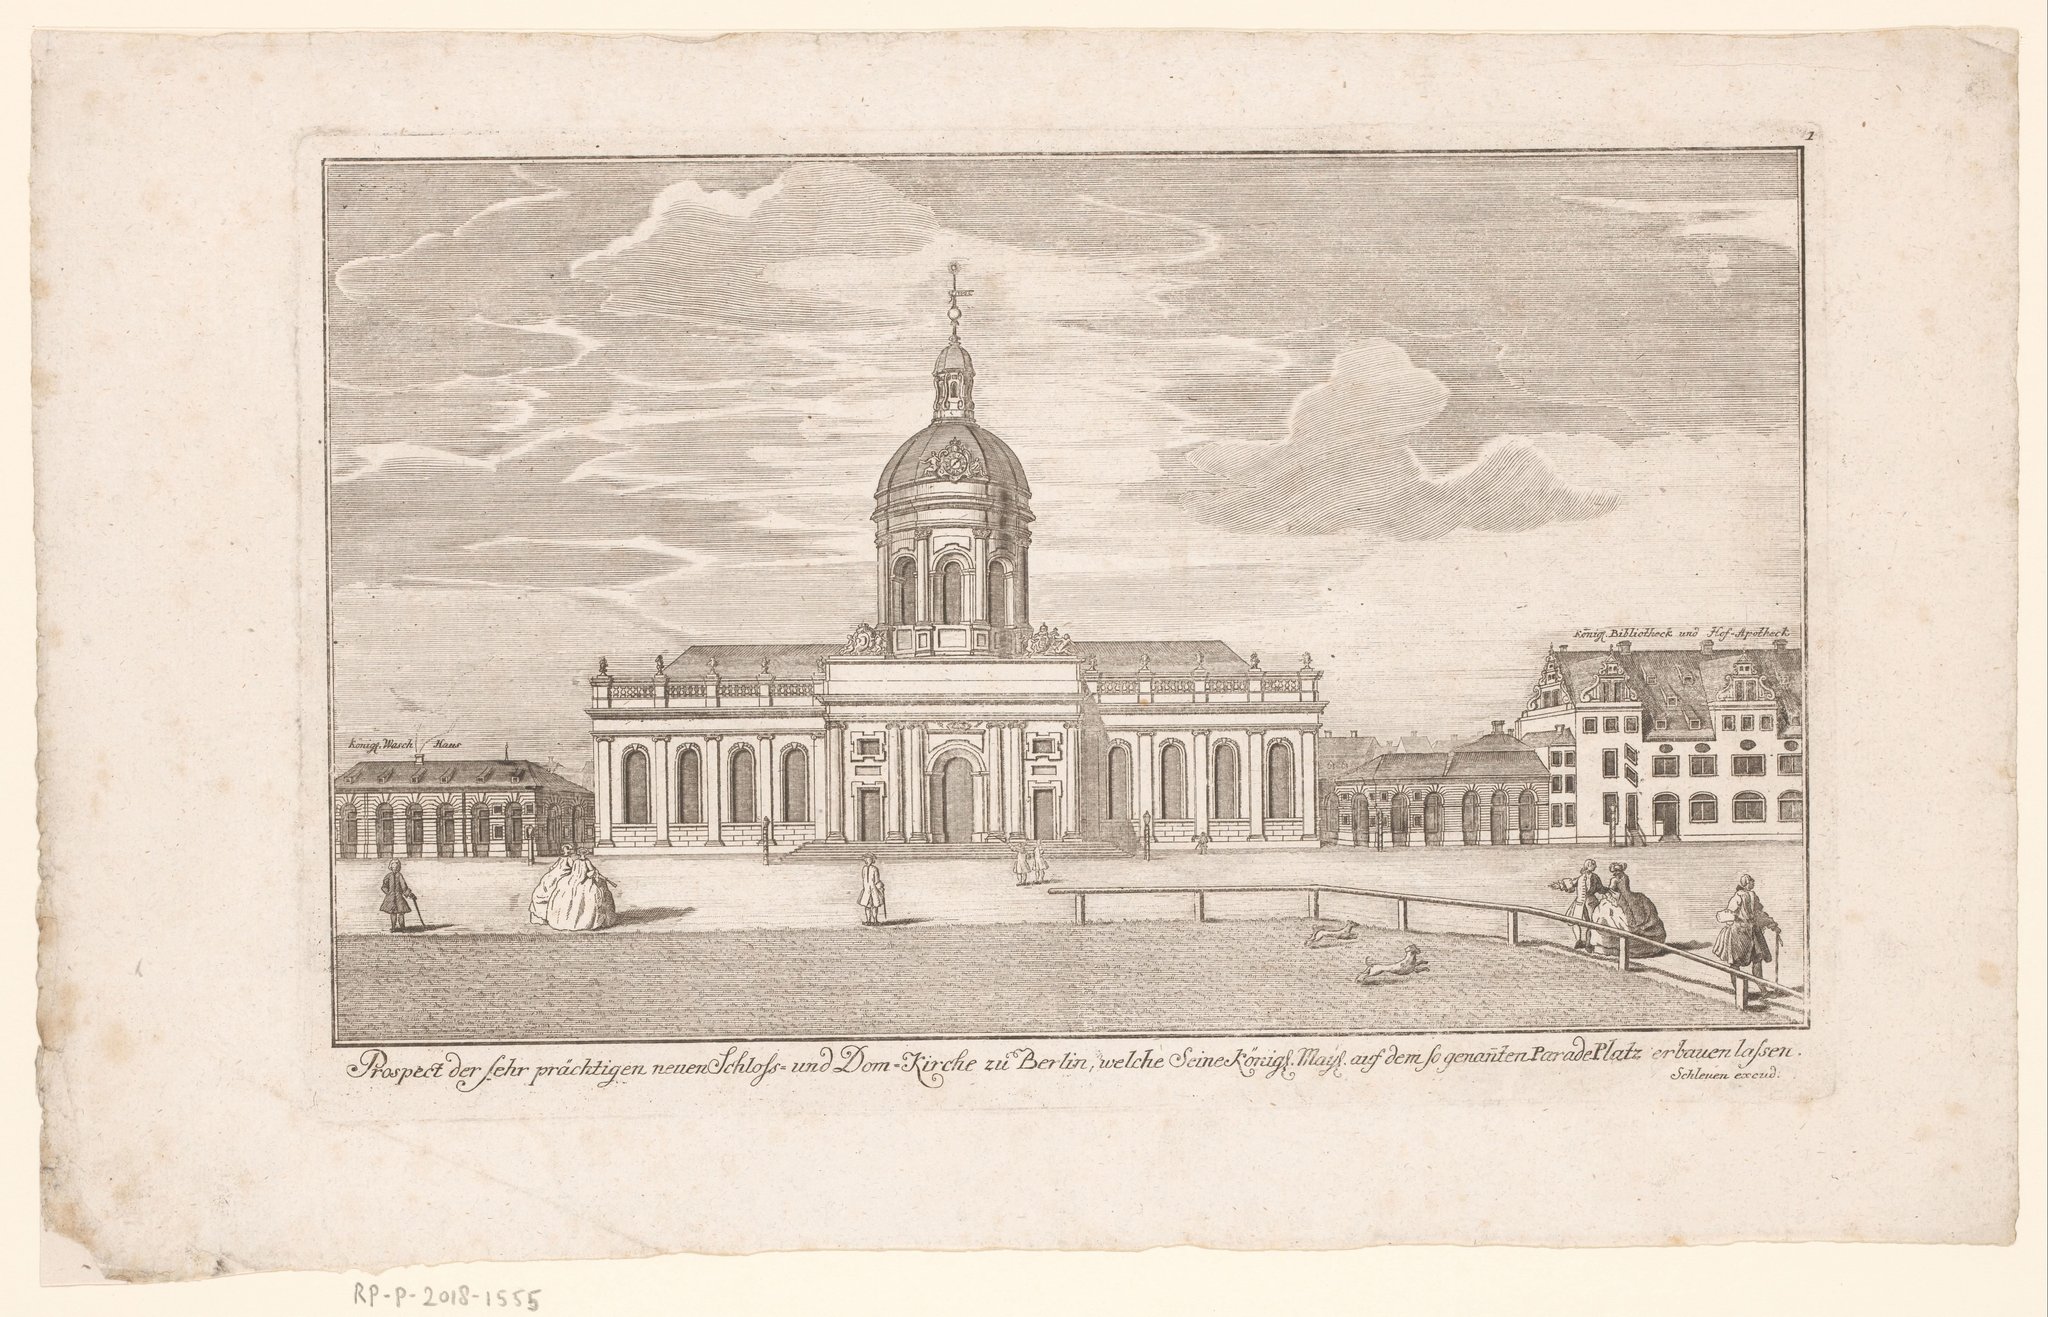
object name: print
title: Gezicht op de Alte Domkirche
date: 1750-1774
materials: paper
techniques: engraving, etching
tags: church (exterior)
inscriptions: collector's mark: Lugt 2228